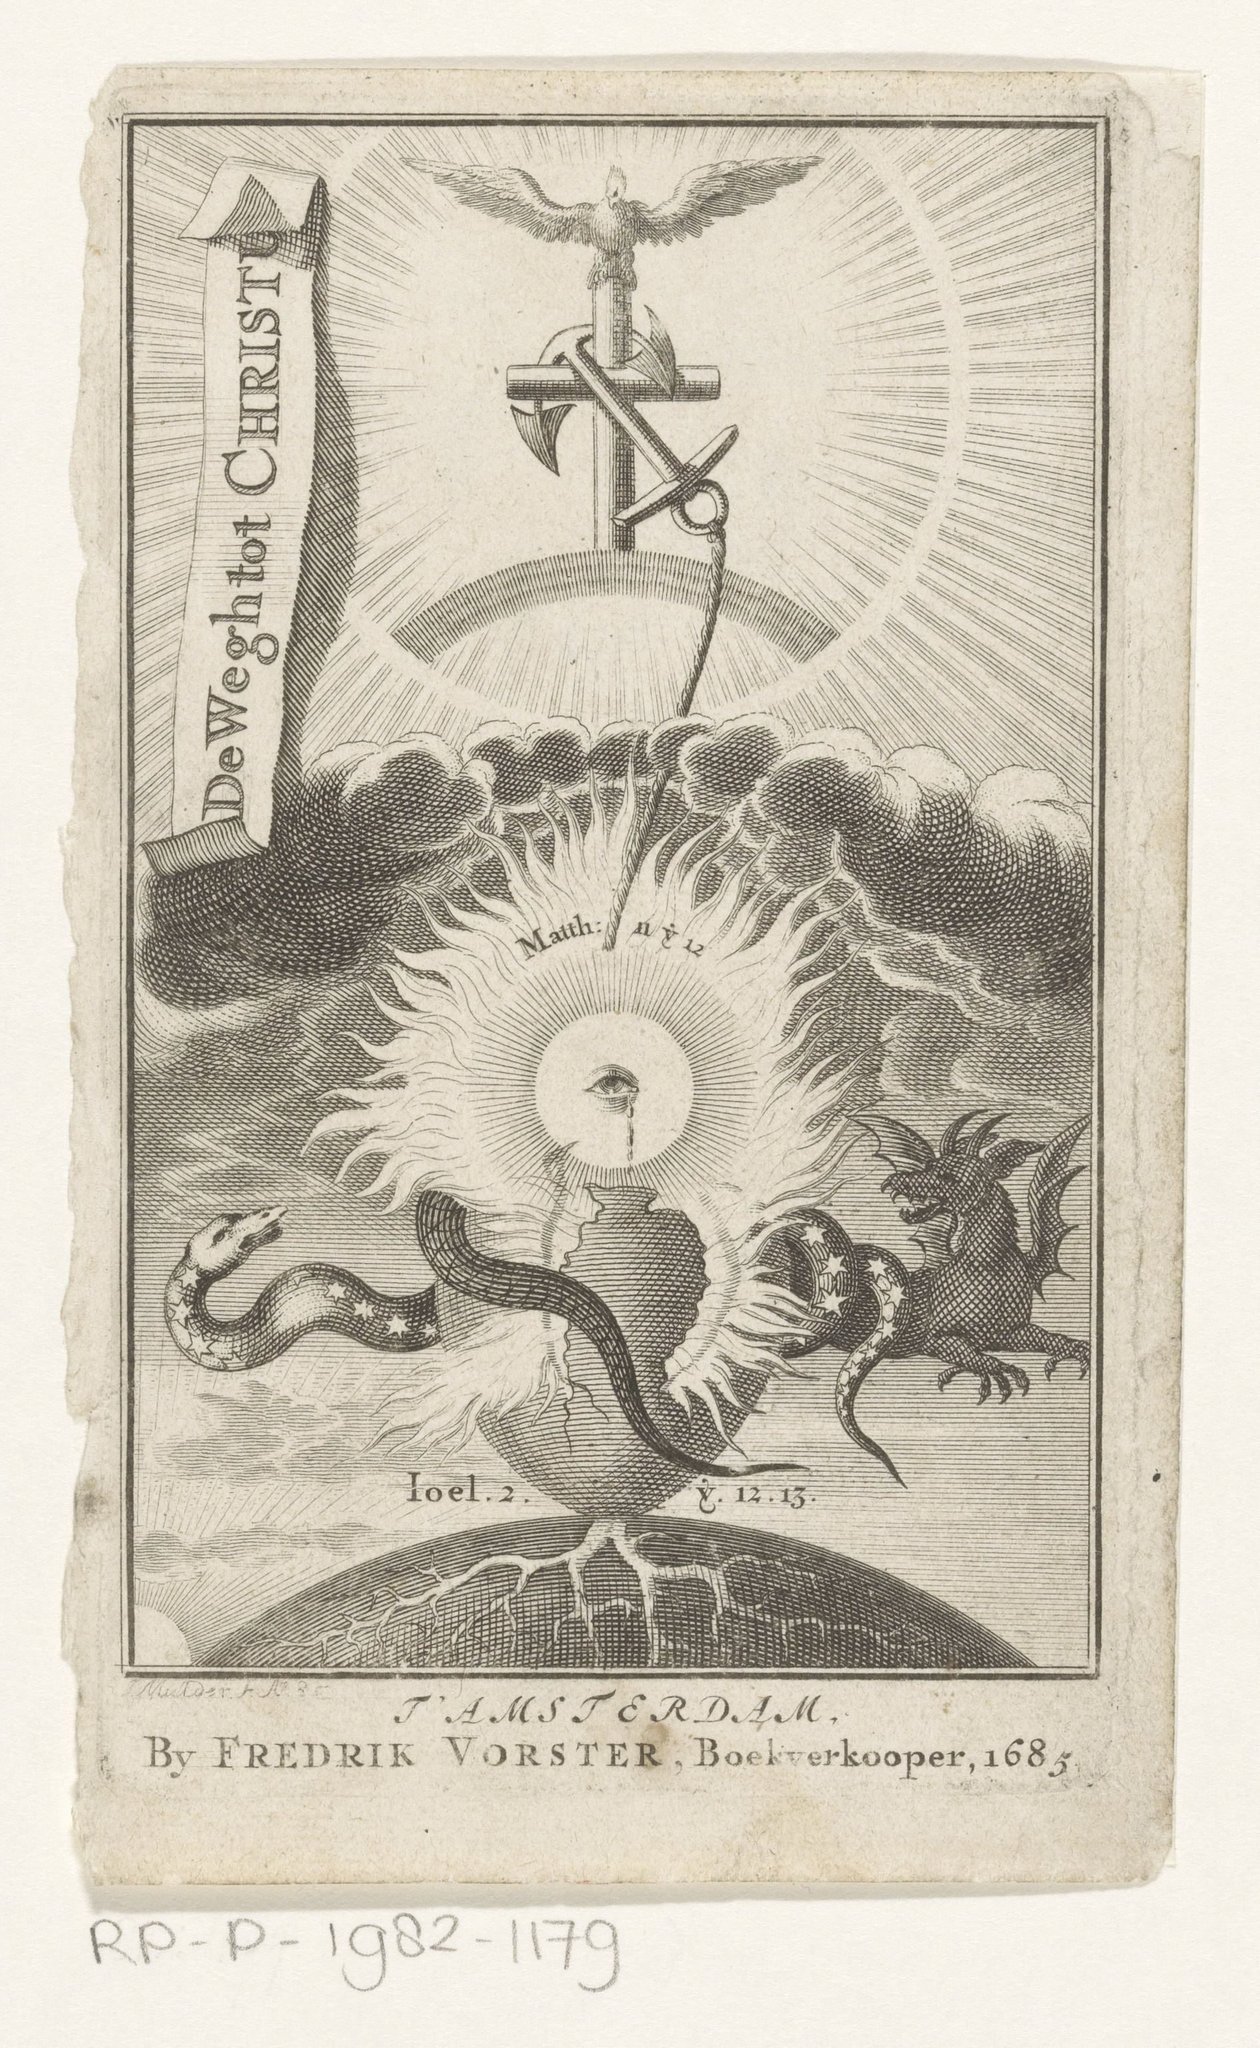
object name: print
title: Allegorische voorstelling met Hemel en Aarde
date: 1685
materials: paper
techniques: engraving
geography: amsterdam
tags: earth, world as celestial body, heaven, celestial paradise, new earth, journey to heaven, pathway to heaven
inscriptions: collector's mark: Lugt 2760, collector's mark: Lugt 2228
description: Een duif in stralenkrans zittend op een kruis met anker. Daaronder donkere wolken boven een huilend oog in stralenkrans dat in de aarde geworteld is. Links en rechts een slang en draak.